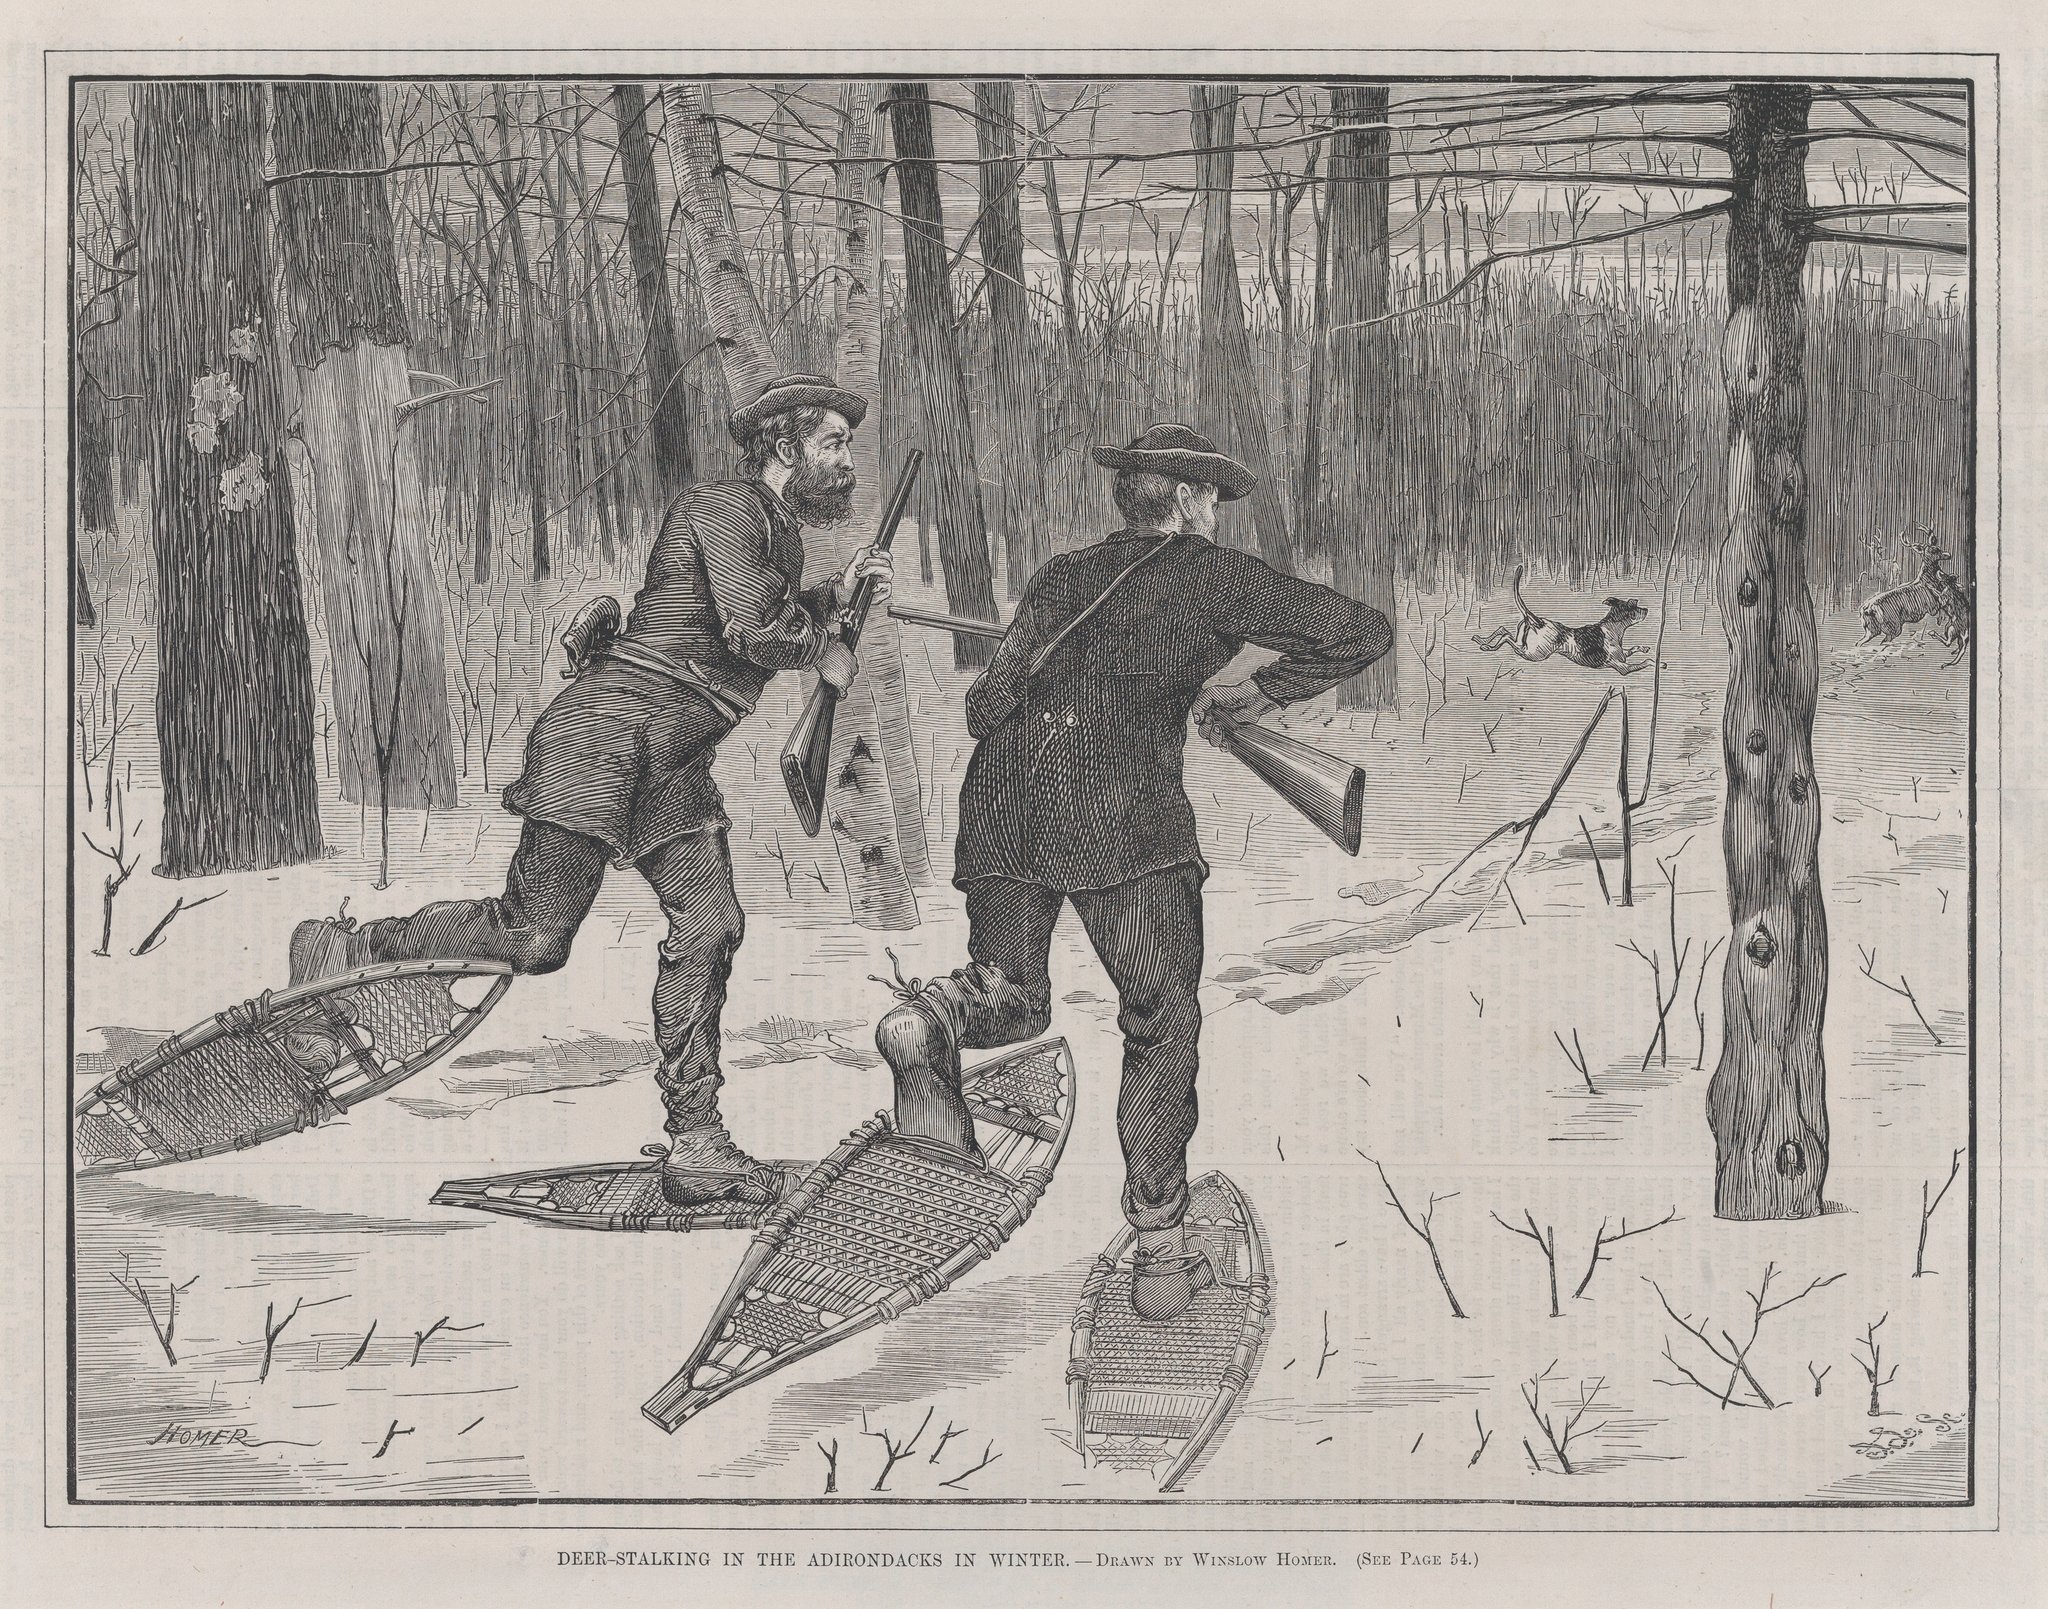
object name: print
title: Deer-Stalking in the Adirondacks in Winter (Every Saturday, Vol. II, New Series)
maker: winslow homer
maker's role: artist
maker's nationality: american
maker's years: 1836-1910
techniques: engraving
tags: men,hunting,deer,dogs,winter